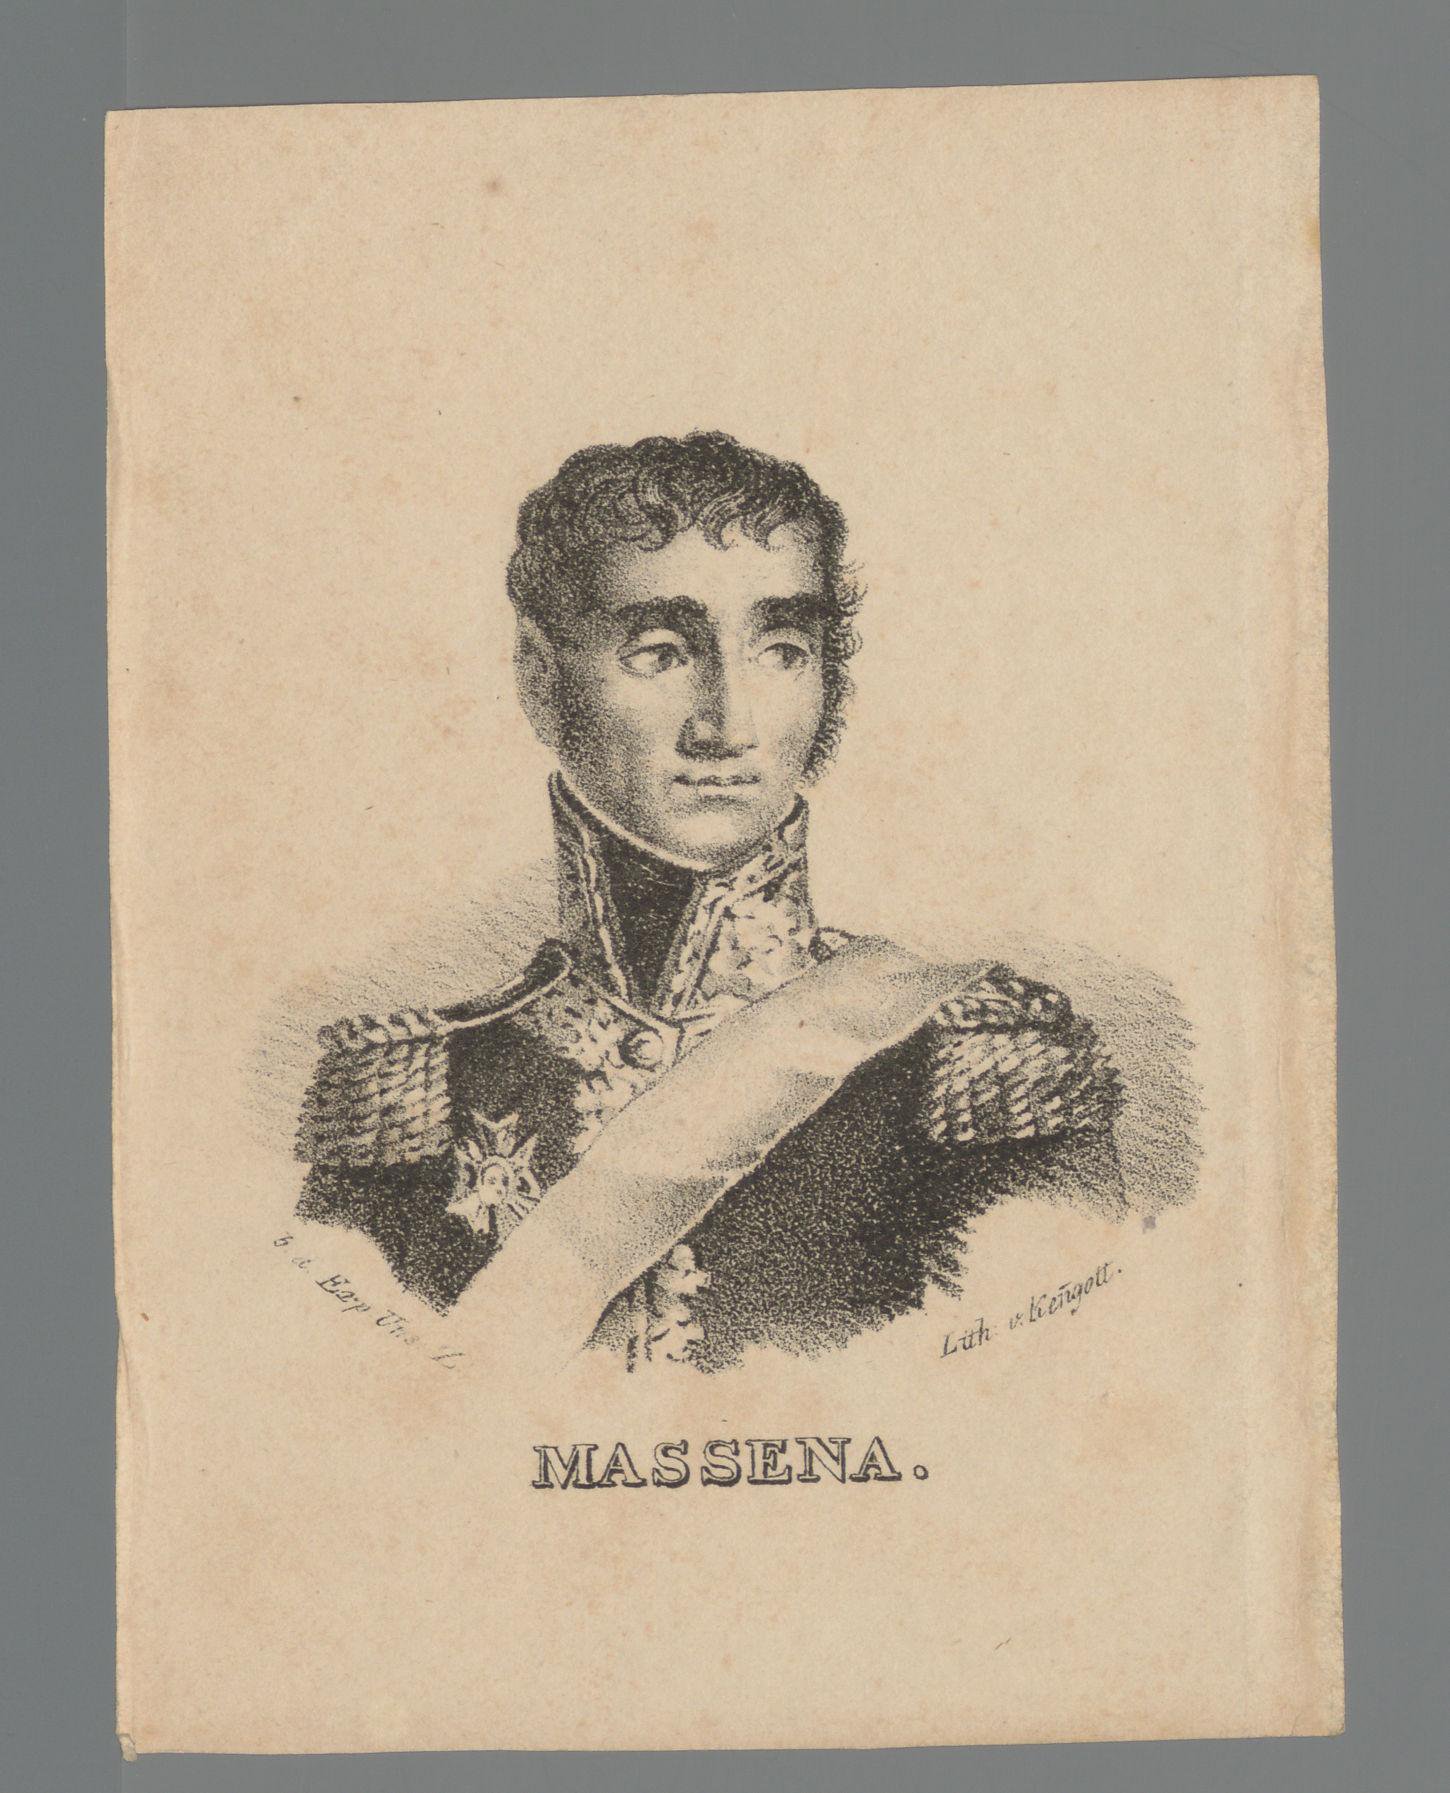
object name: print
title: Portret van André Masséna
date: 1820-1850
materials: paper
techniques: lithograph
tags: adult man, historical persons, (military) uniforms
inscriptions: collector's mark: Lugt 2228, inscription: ‘[3/b]. d. Exp. Uns. Z.’